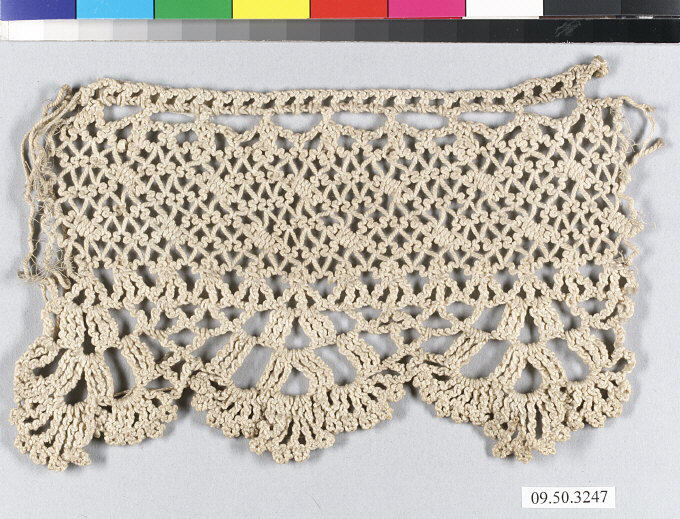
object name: sample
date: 1801-1900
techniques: crochet